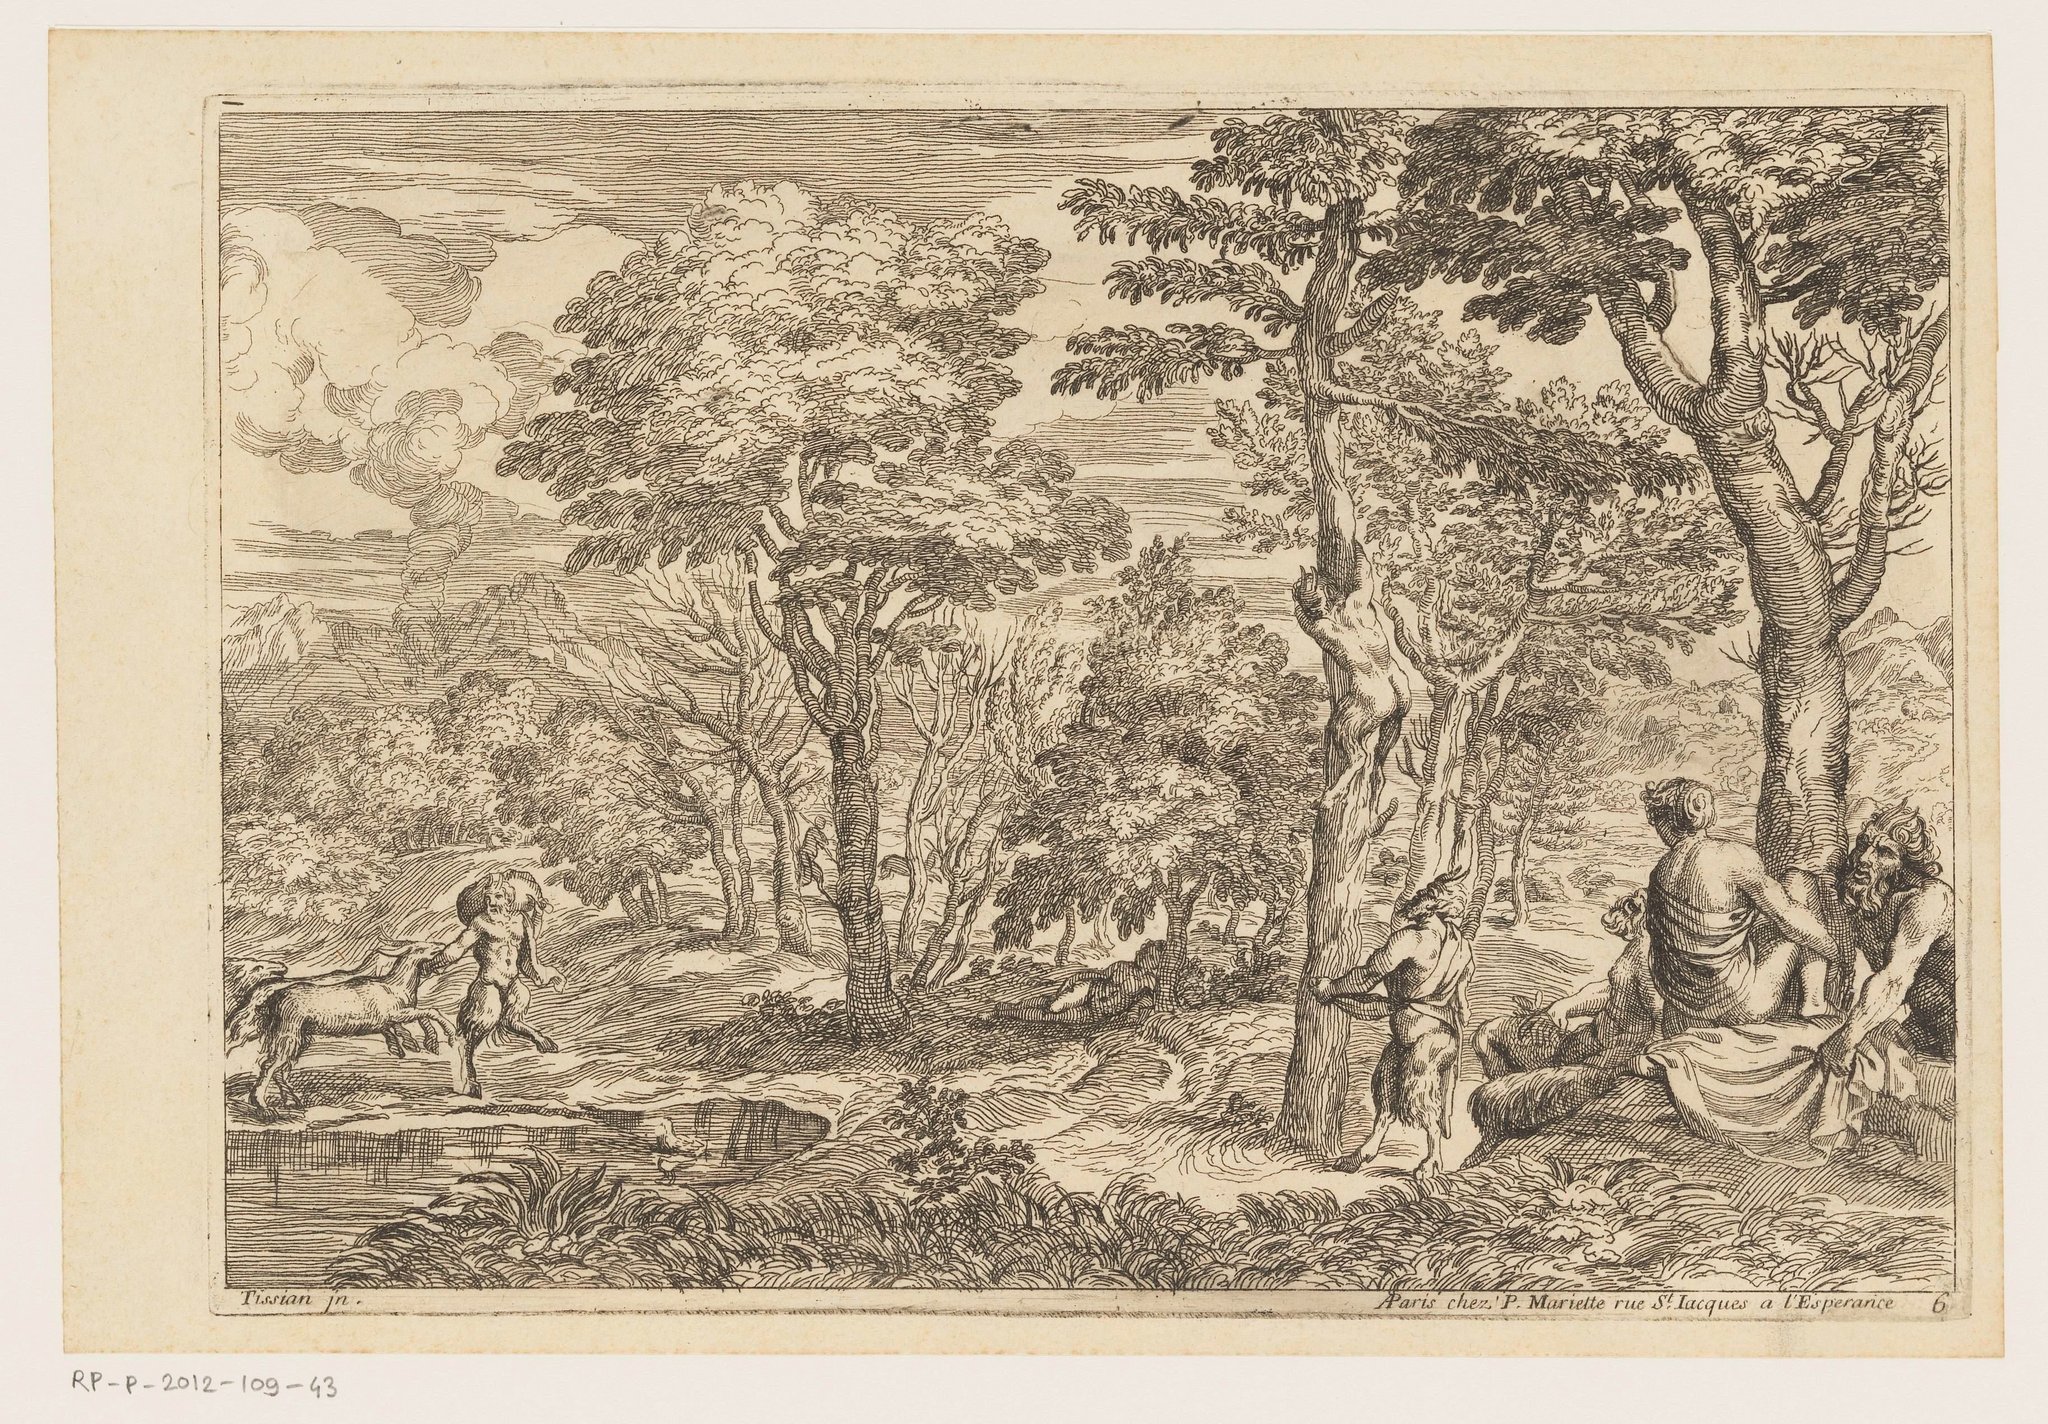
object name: print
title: Landschappen naar Titiaan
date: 1663-1726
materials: paper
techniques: etching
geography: paris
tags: satyrs, fauns, sileni, forest, wood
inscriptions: collector's mark: Lugt 3473, collector's mark: Lugt 2228, collector's mark: Lugt 3474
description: Maakt deel uit van vierentwintigdelige serie met landschappen naar Titiaan en Campagnola.